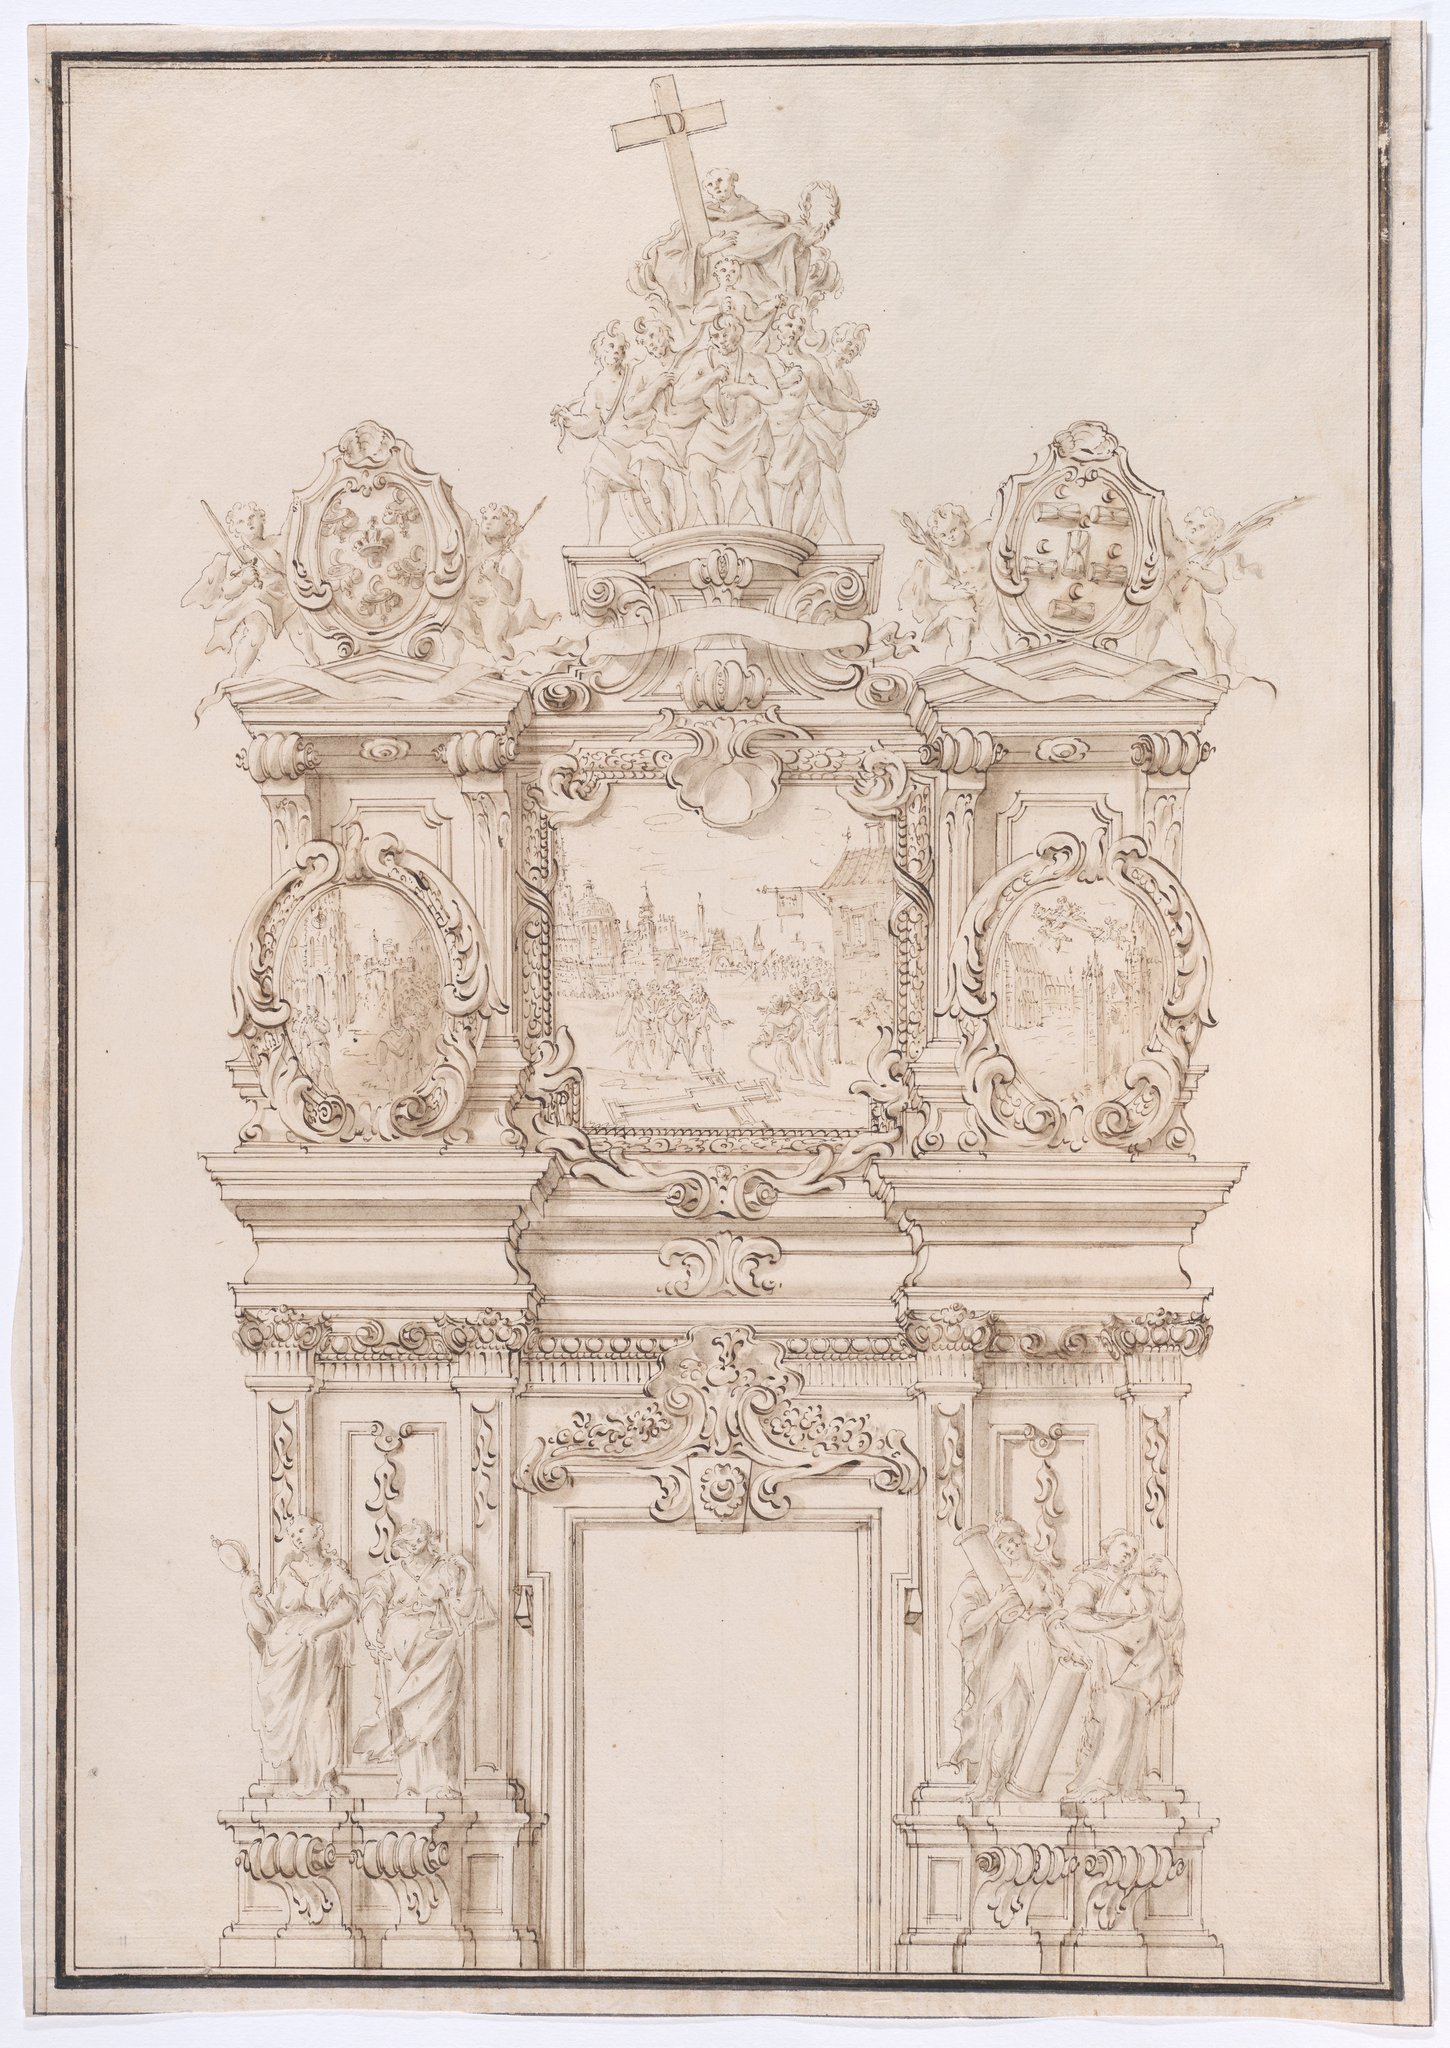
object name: drawing ornament architecture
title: Elevation for a Wall Decoration Scheme for a Church Interior with Scenes dedicated to the Legend of the Holy Cross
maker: anonymous, central european, 18th century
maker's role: artist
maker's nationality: central european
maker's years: 1700-1800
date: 1710-1730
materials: graphite, ink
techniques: pen